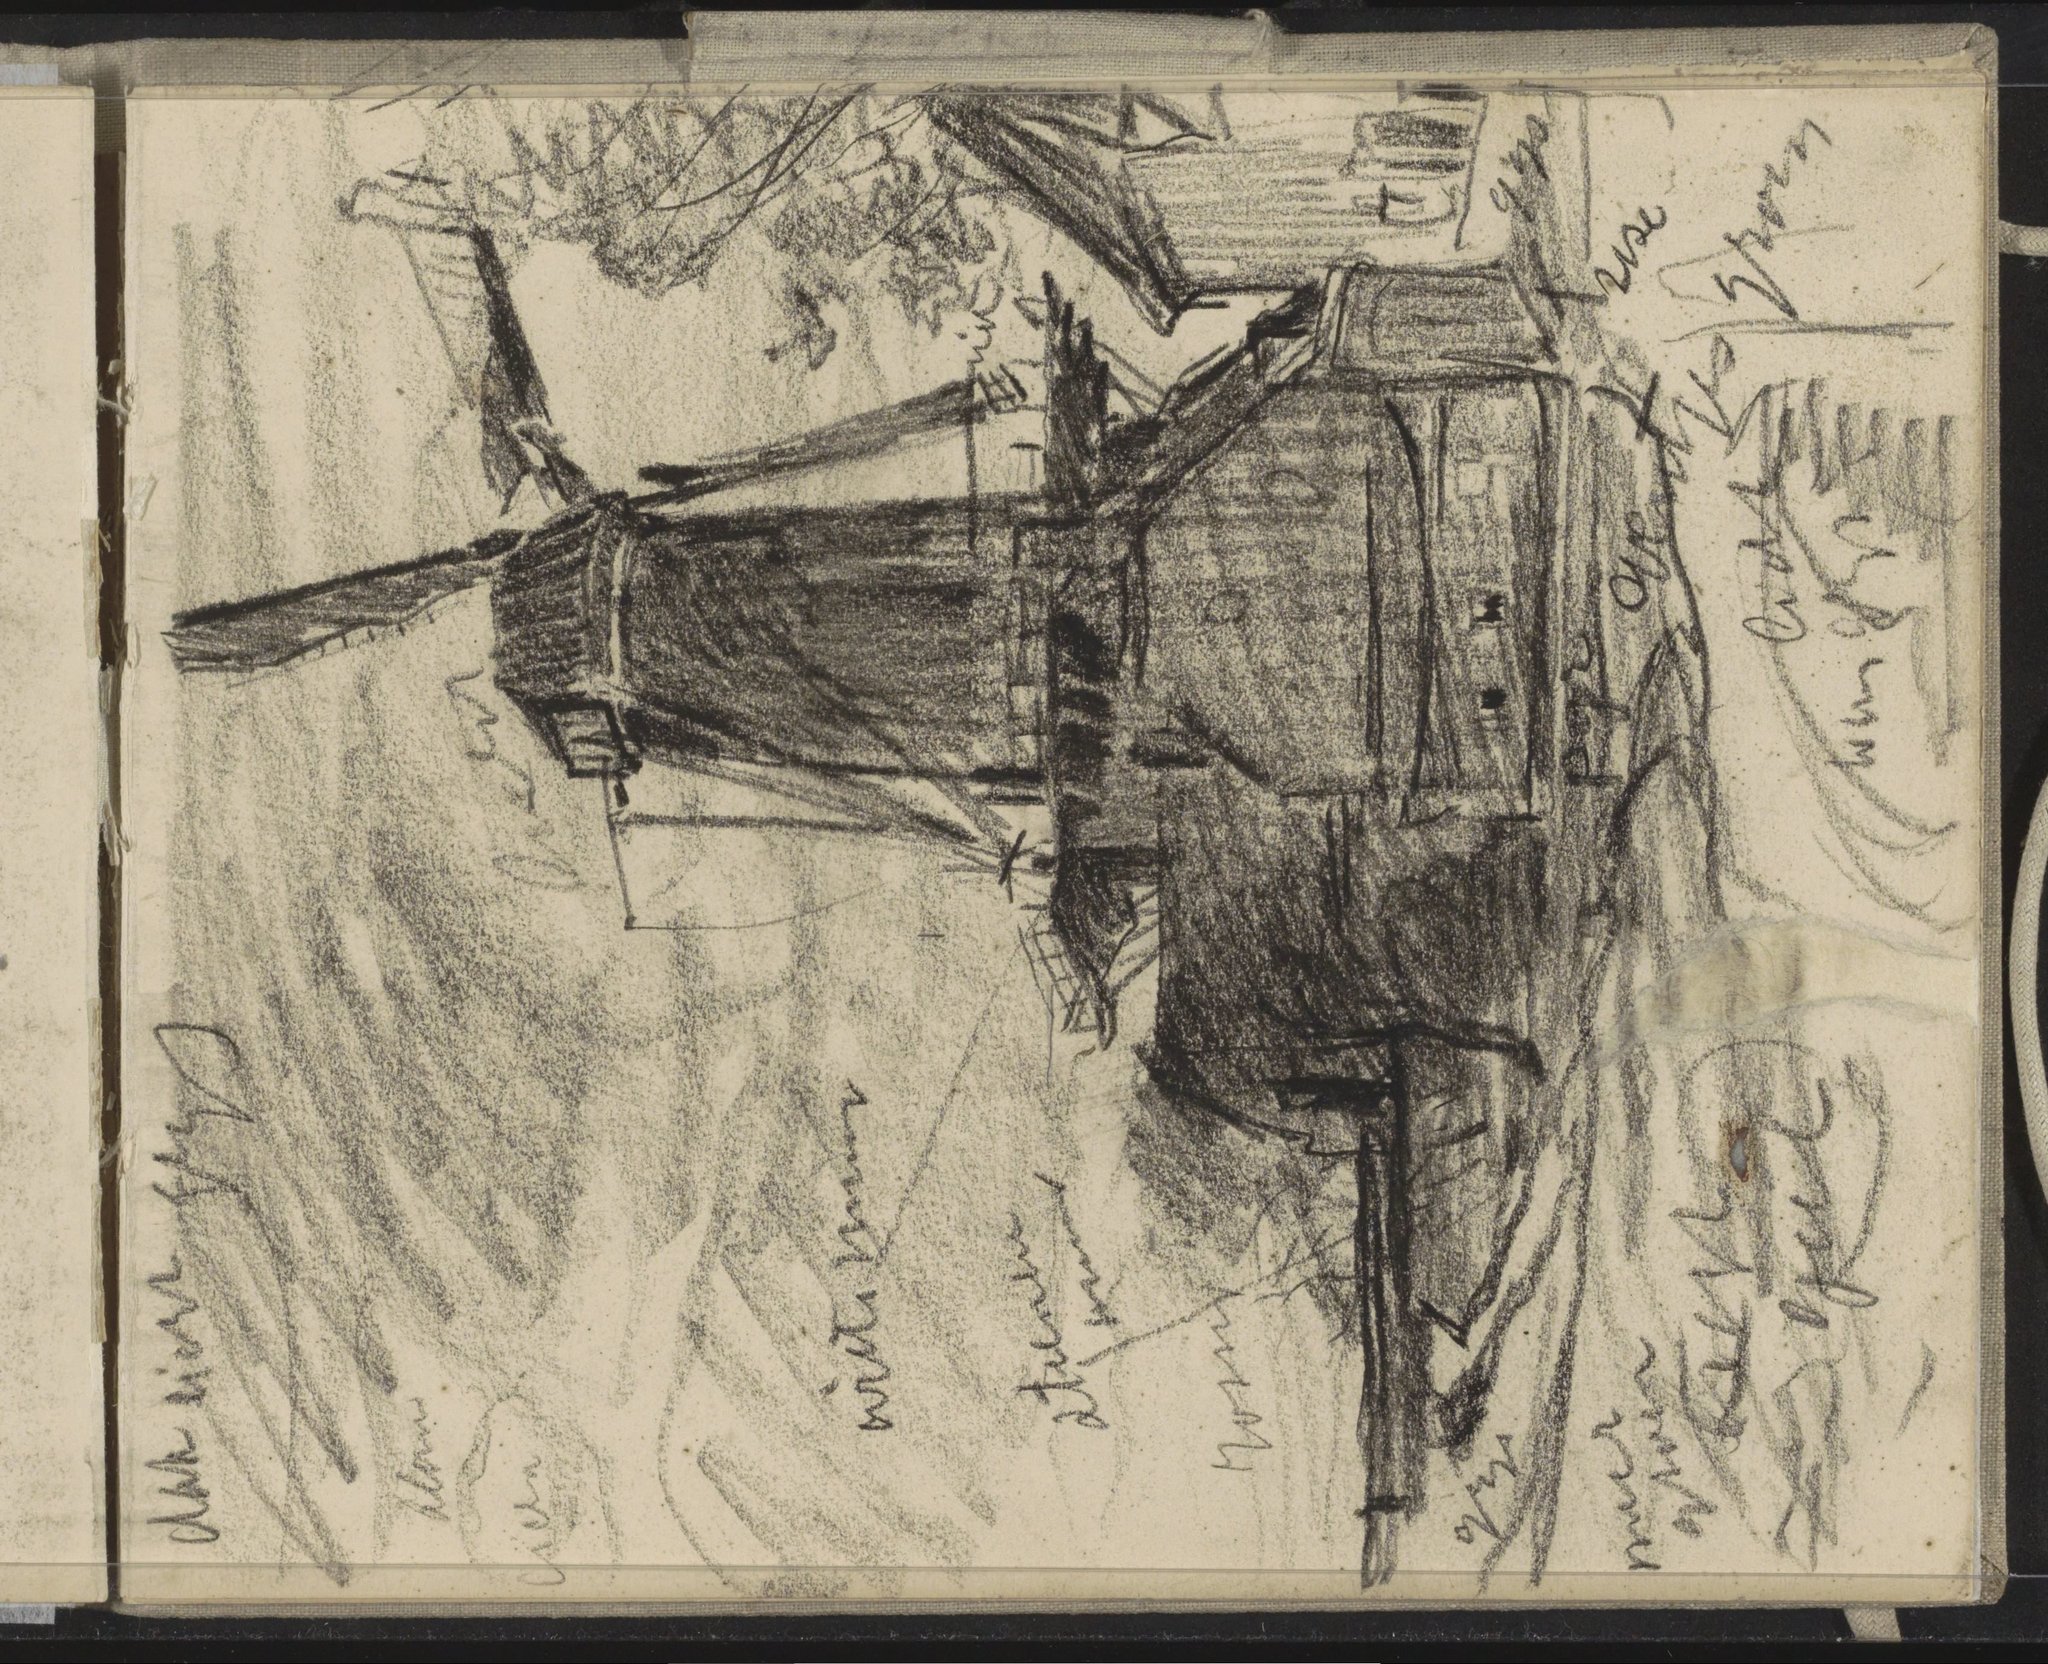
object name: sketchbook leaf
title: Gezicht op de molen Rijn en Lek te Wijk bij Duurstede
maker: willem witsen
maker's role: draughtsman, painter, print maker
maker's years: 1860-1923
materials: chalk, paper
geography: wijk bij duurstede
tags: urban housing, windmill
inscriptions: kleurnotitie, handgeschreven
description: Voorstudie voor de ets 'Korenmolen, Wijk bij Duurstede', ca. 1908.